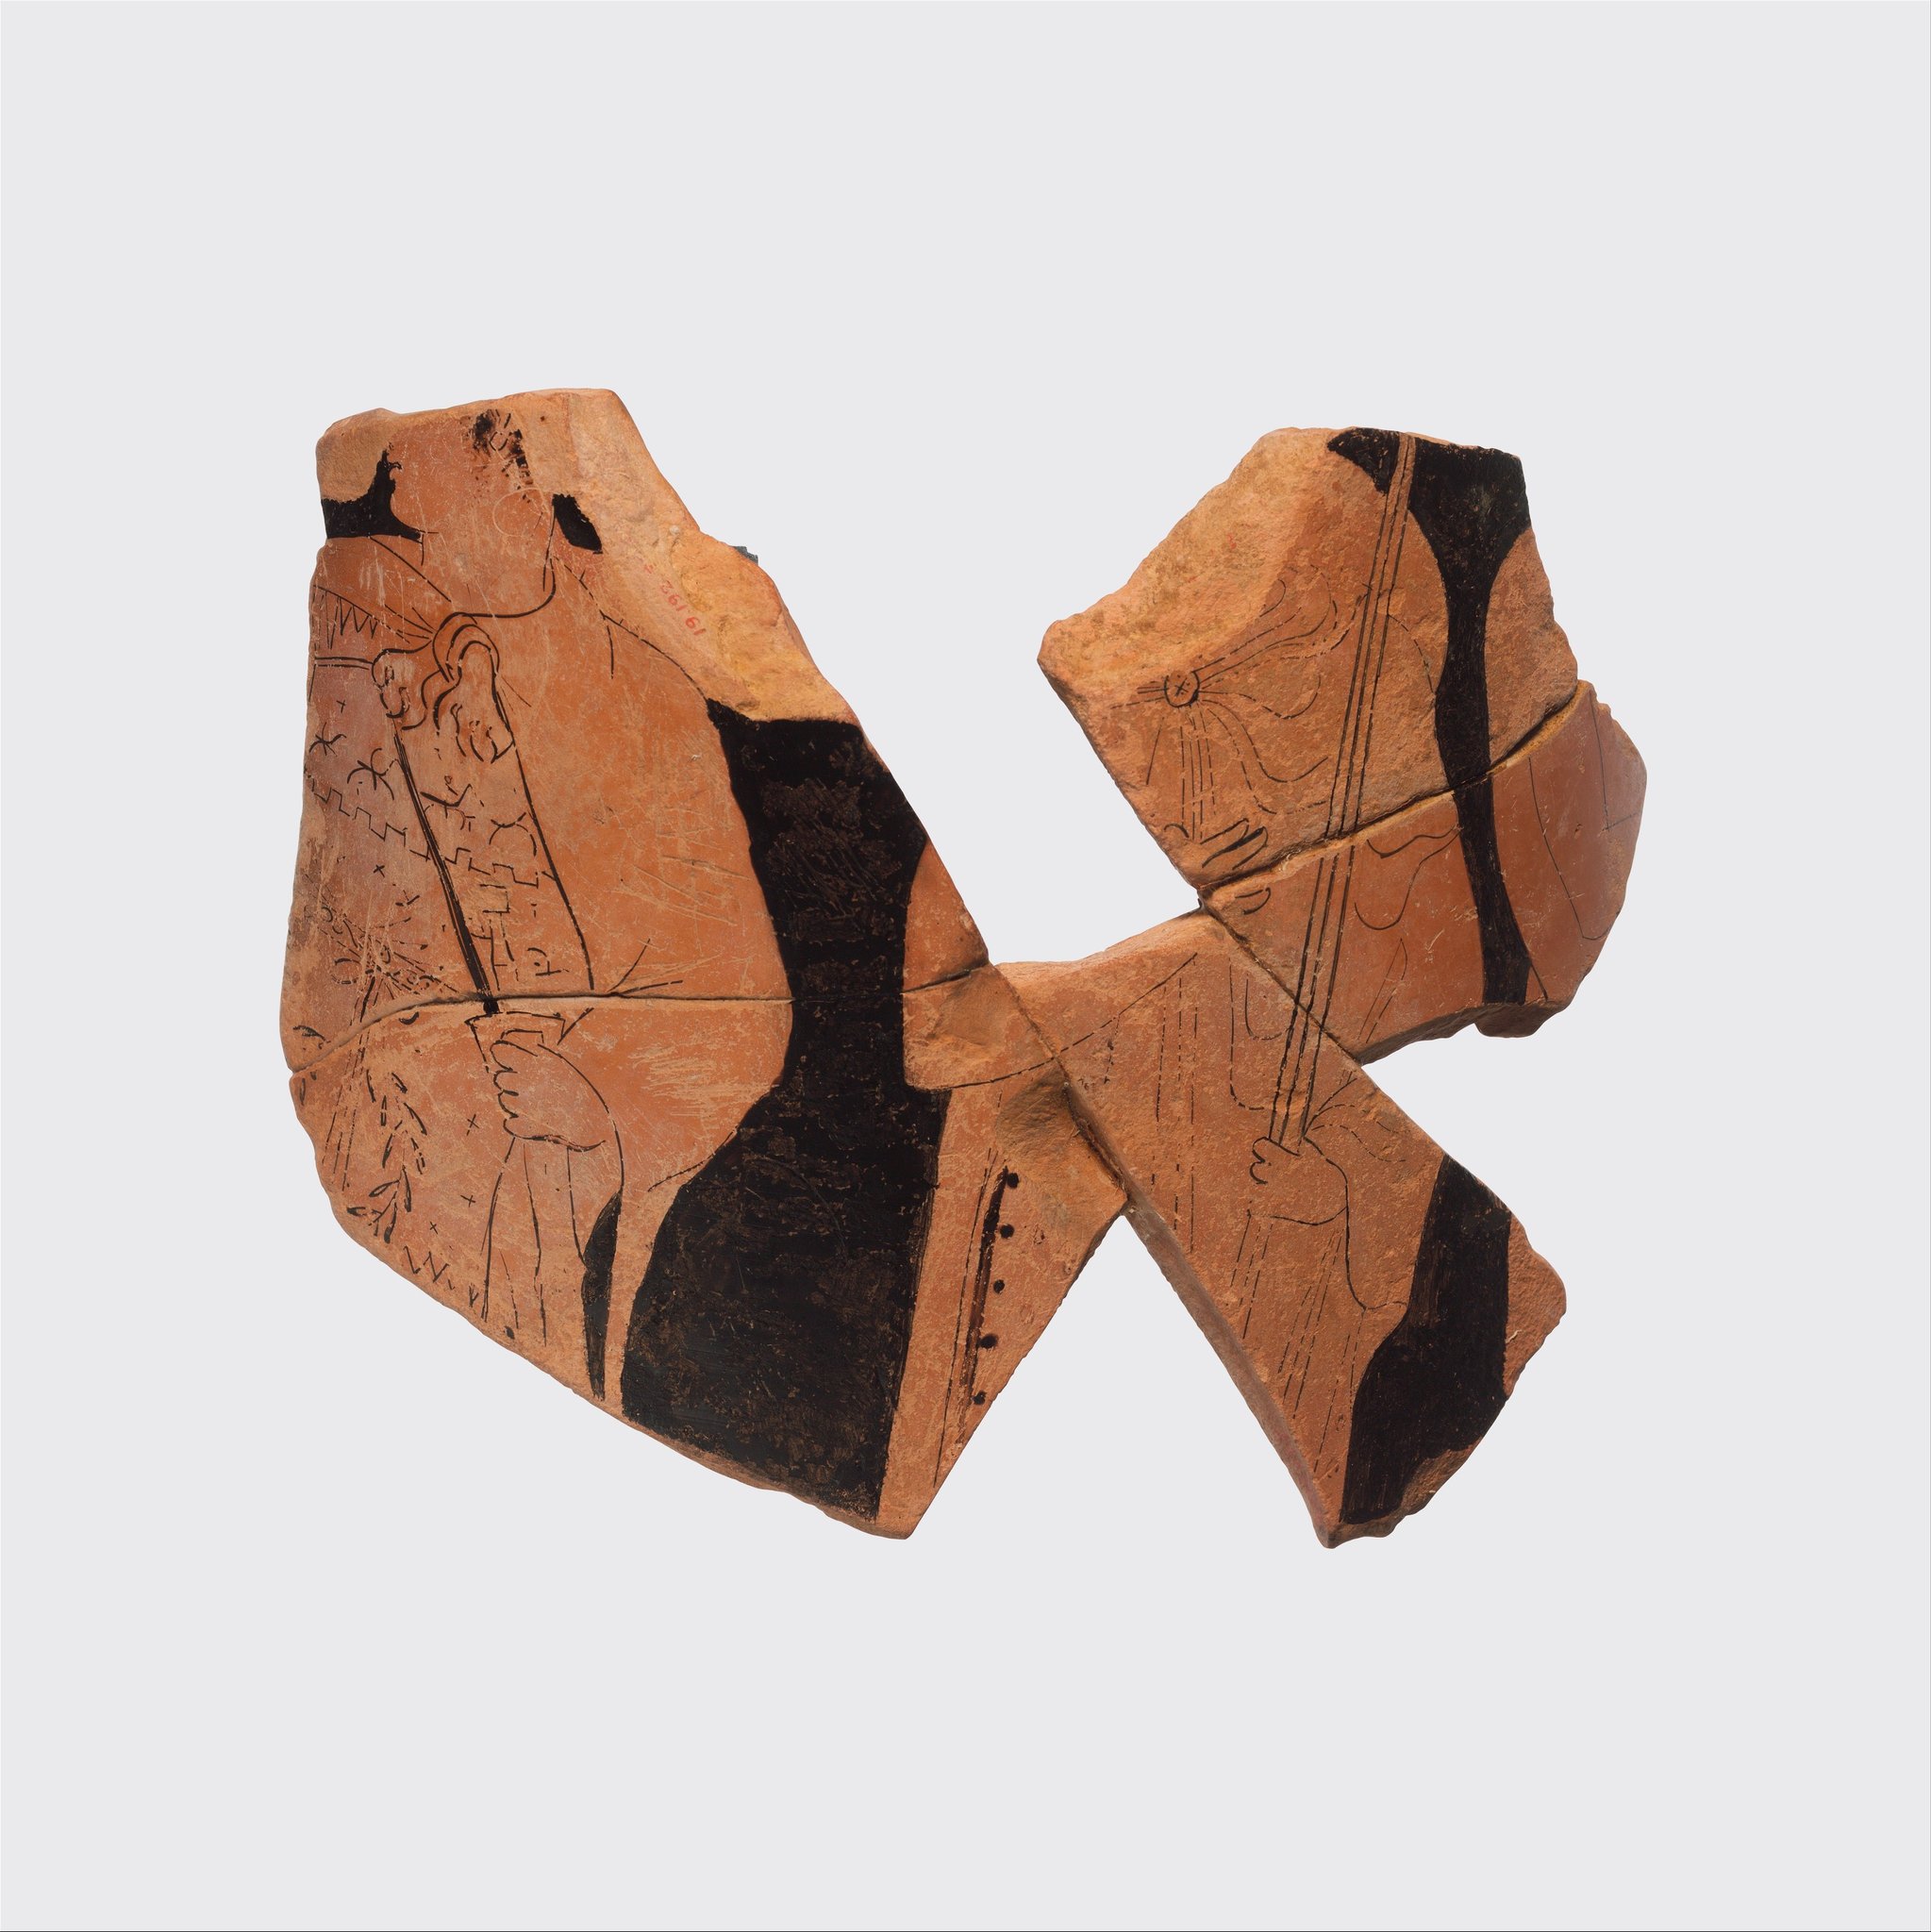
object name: lebes gamikos, fragment of stand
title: Fragmentary stand of a terracotta lebes gamikos (round-bottomed bowl with handles and stand used in weddings)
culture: greek, attic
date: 450-426 BCE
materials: terracotta